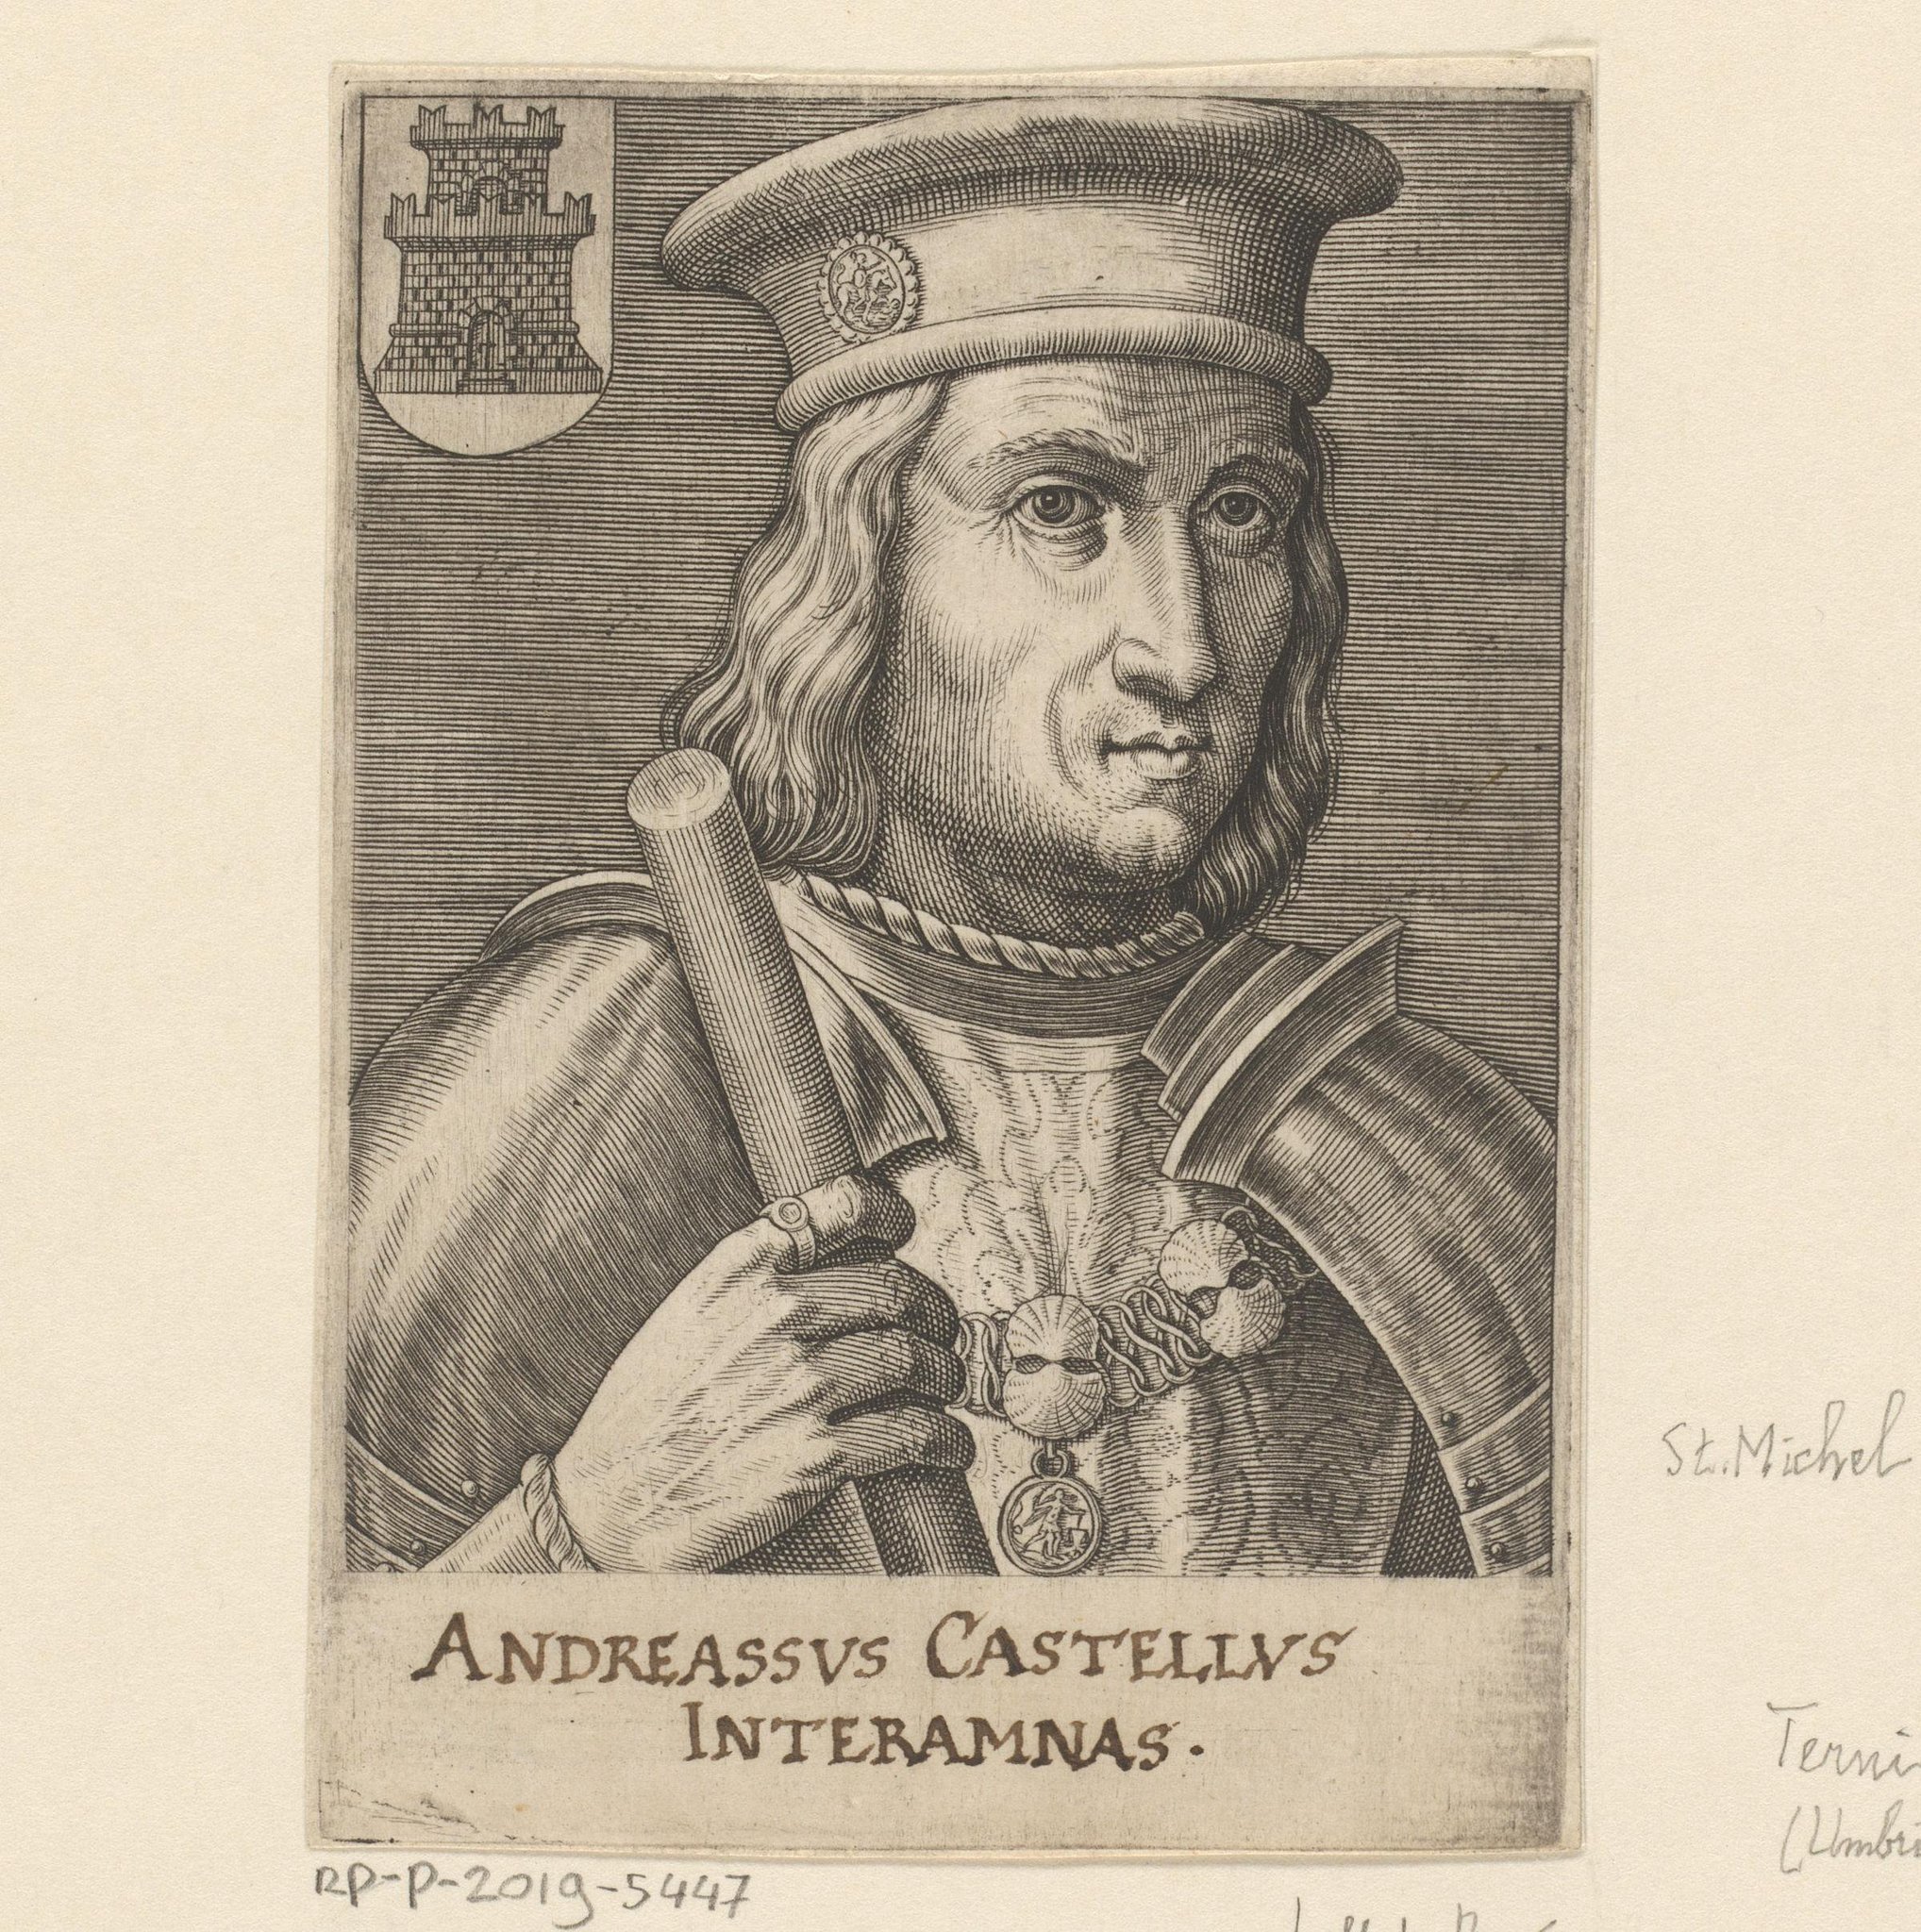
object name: print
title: Portret van Andreasso Castello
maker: Anonymous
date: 1600-1699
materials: paper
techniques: engraving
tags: historical persons